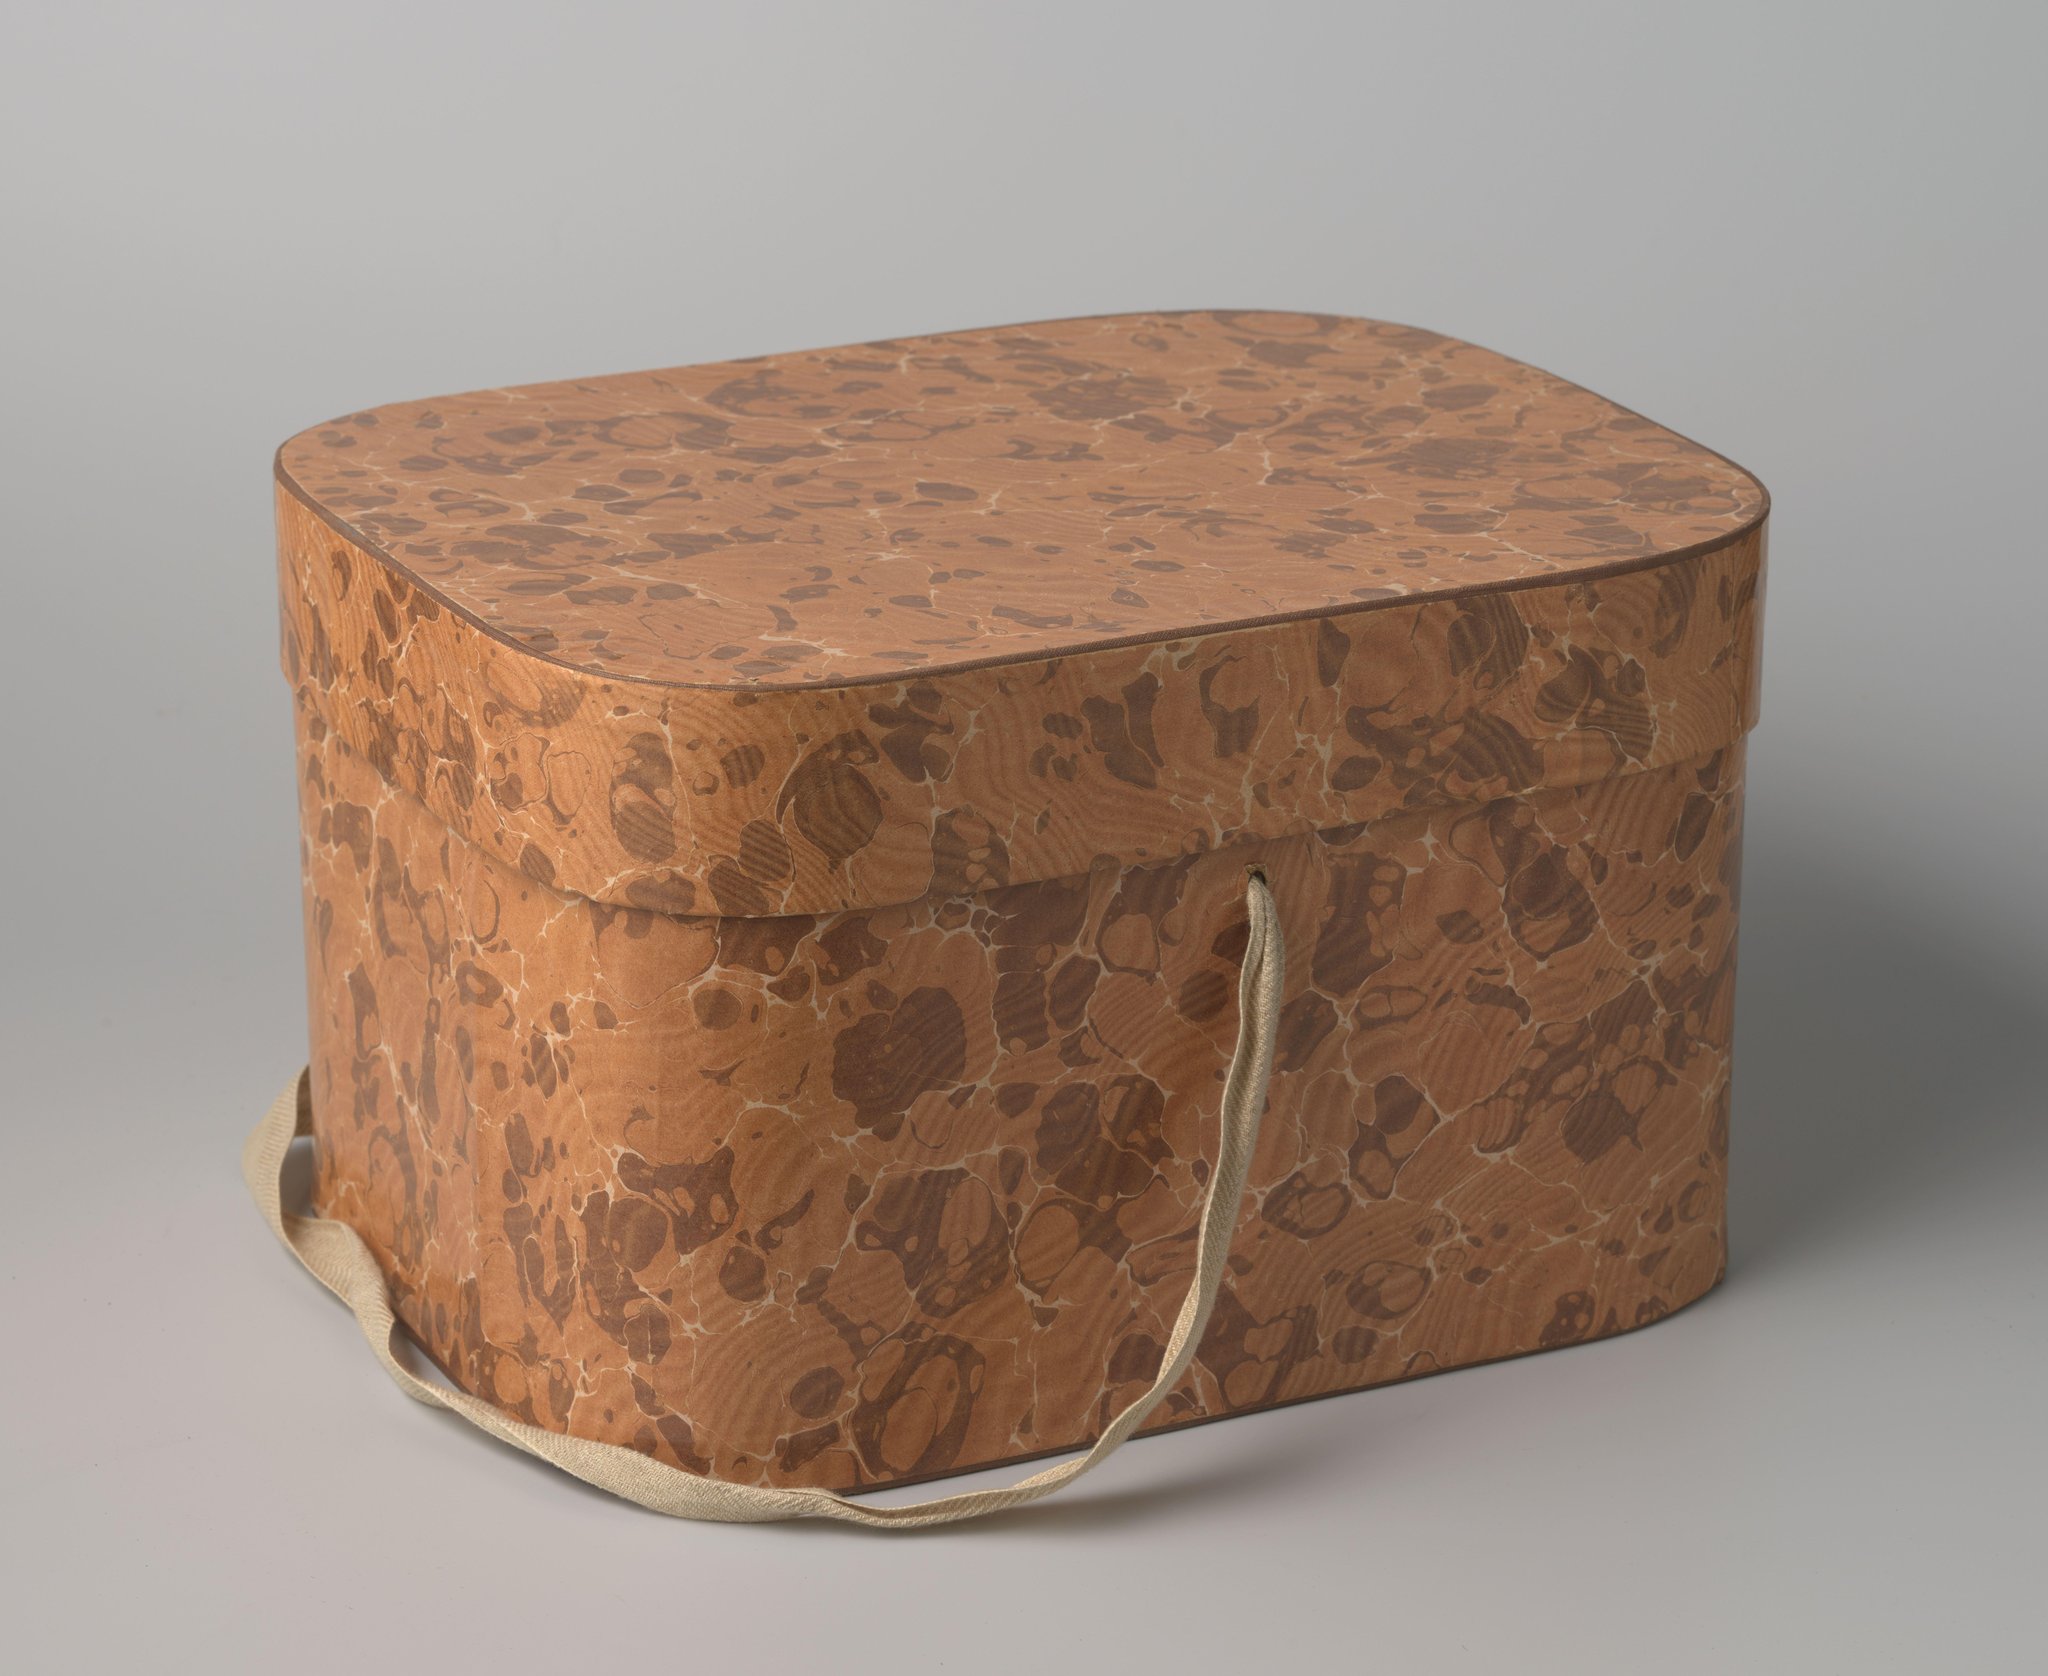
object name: womenswear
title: Hoedendoos van karton, rechthoekig met afgeronde hoeken en beplakt met gemarmerd papier in licht- en donkerbruin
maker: Anonymous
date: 1900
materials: cardboard, linen, paper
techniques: marbling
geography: netherlands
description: Hoedendoos van karton, rechthoekig met afgeronde hoeken en beplakt met gemarmerd papier in licht- en donkerbruin. De binnenzijde is bekleed met blauw papier. Met draagband van linnen.